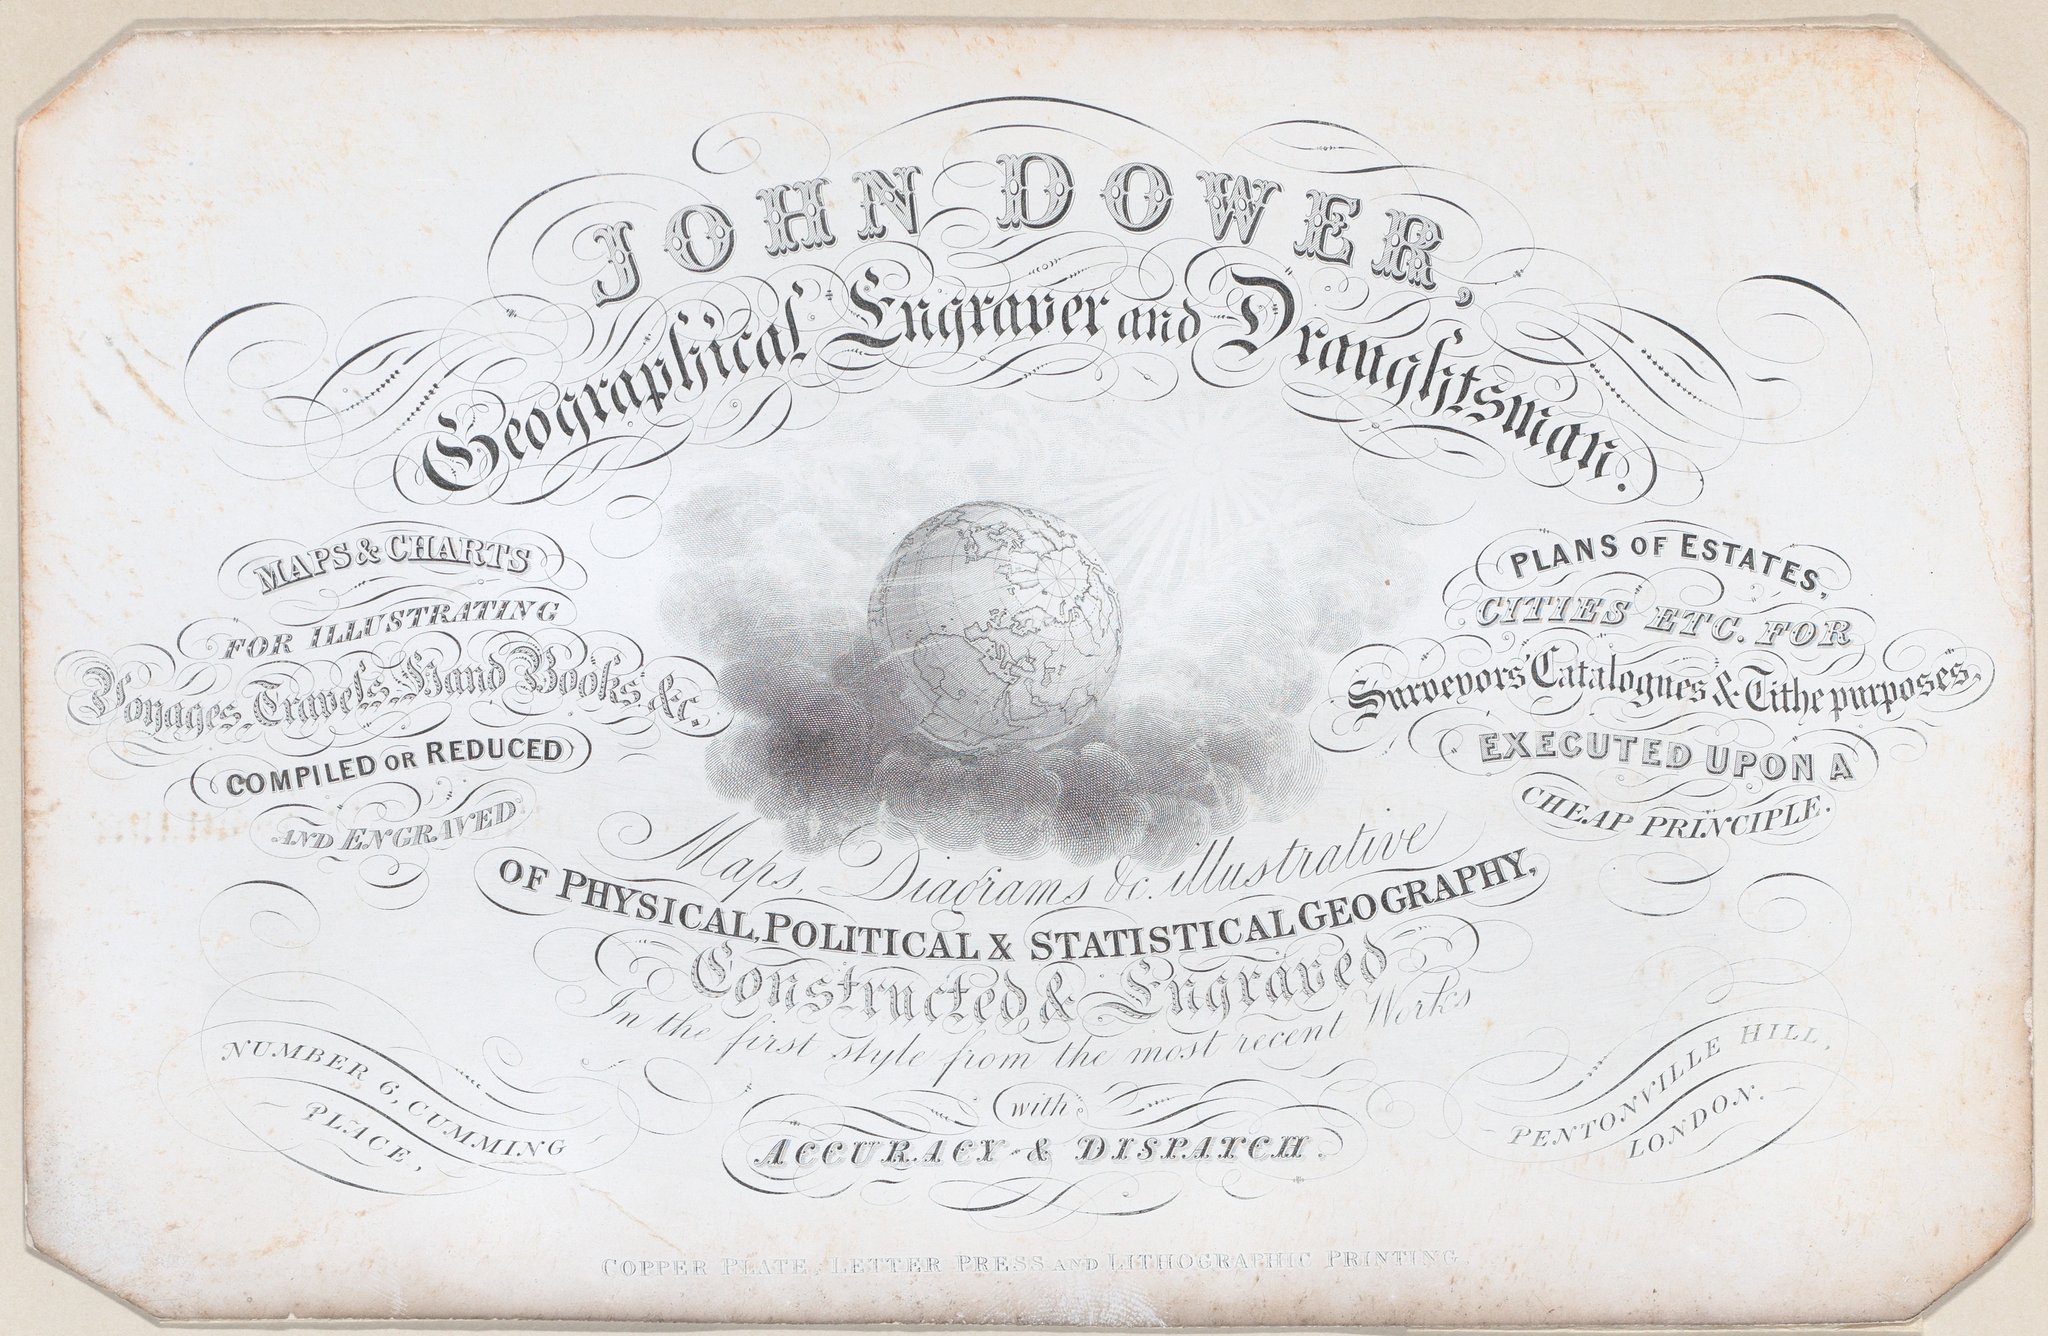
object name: print, trade card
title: Trade card for John Dower, geographical engraver and draughtsman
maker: anonymous, british, 19th century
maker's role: artist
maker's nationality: british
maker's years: 1800-1900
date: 1801-1900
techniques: engraving